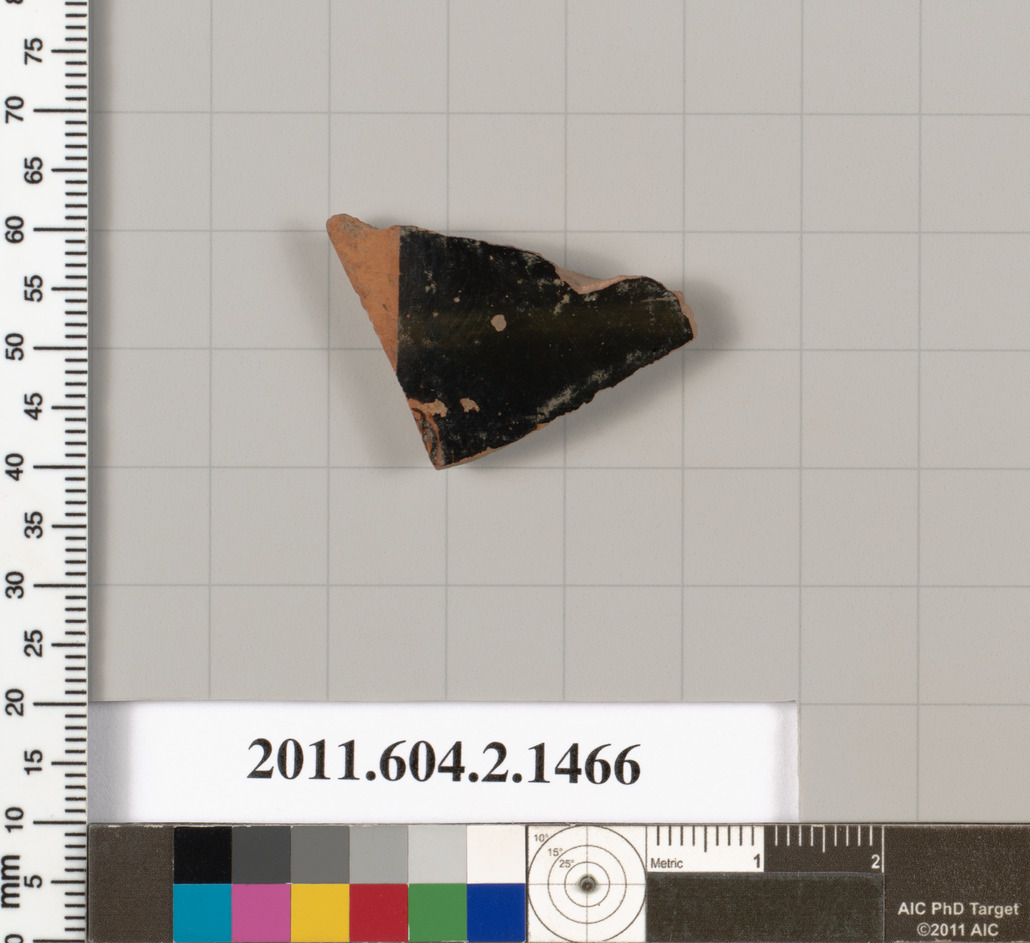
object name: skyphos fragment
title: Terracotta fragment of a skyphos (deep drinking cup)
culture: greek, attic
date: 450-401 BCE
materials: terracotta